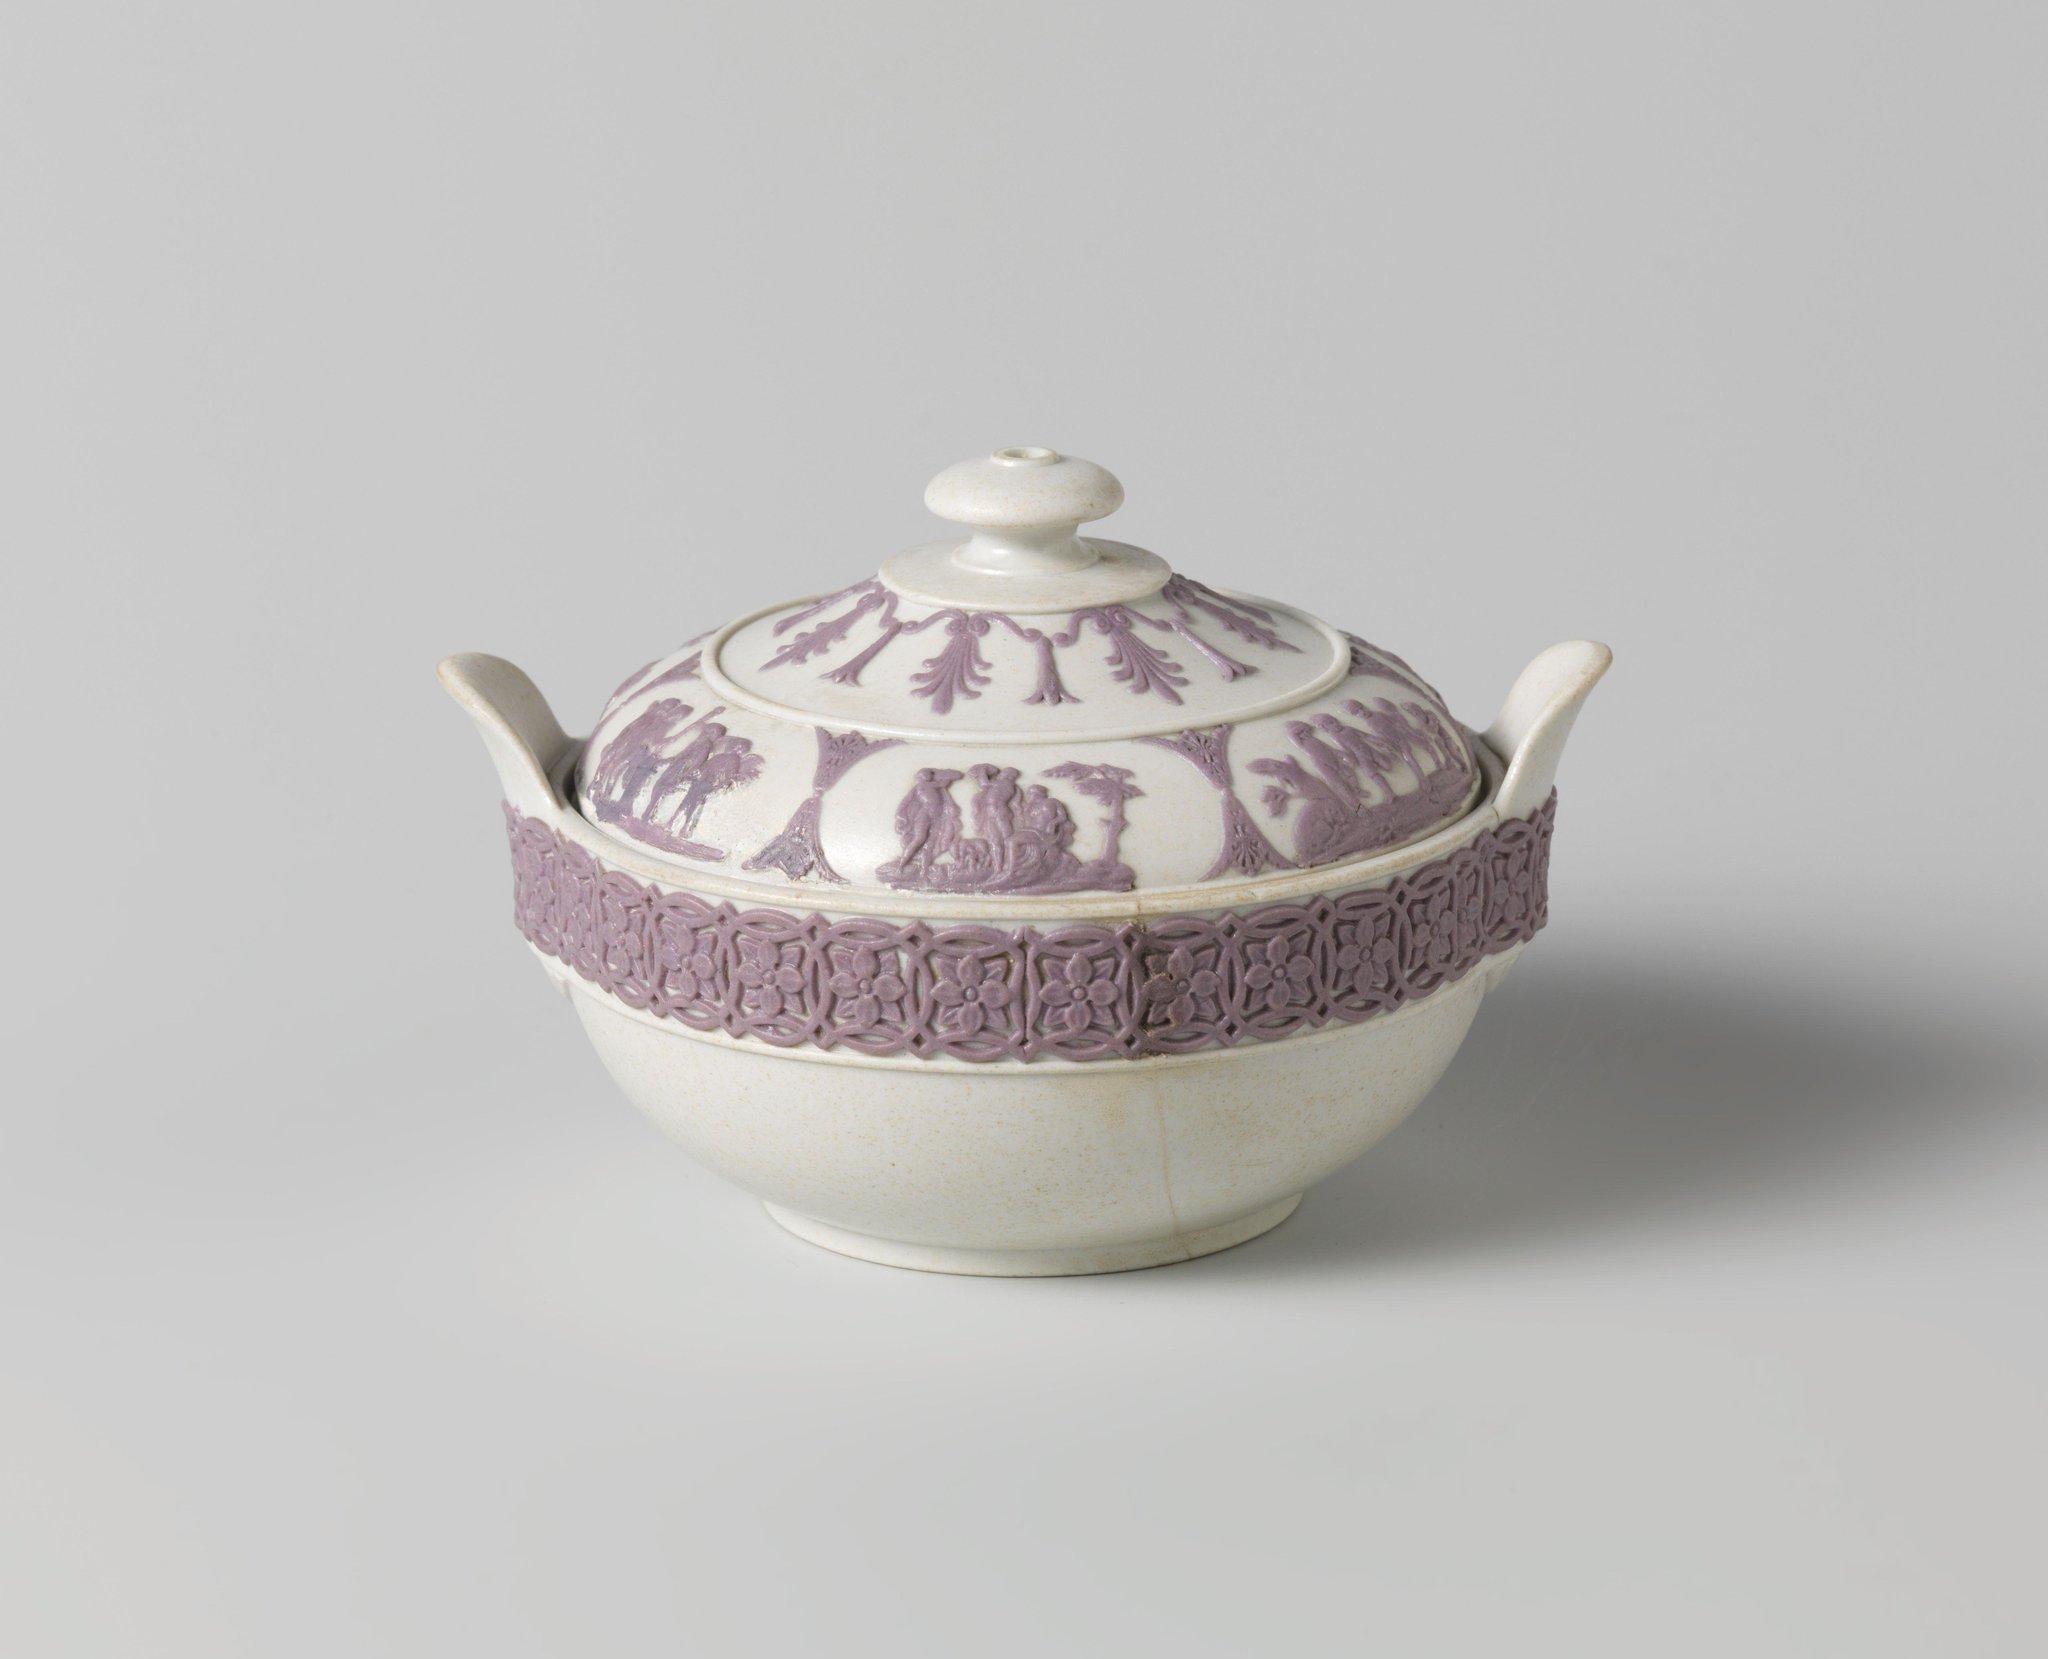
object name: pot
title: Suikerpot van steengoed, versierd met paarse applieken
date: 1790-1810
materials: stoneware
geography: england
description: Suikerpot van steengoed, versierd met paarse applieken. De suikerpot heeft twee opstaande oren. De oren zijn plat en naar buiten gebogen. De bovenrand van de pot is versierd met een ornamentrand met rozetten. De suikerpot is gemerkt. De suikerpot hoort bij een melkkan met invnr. BK-NM-13190-A.